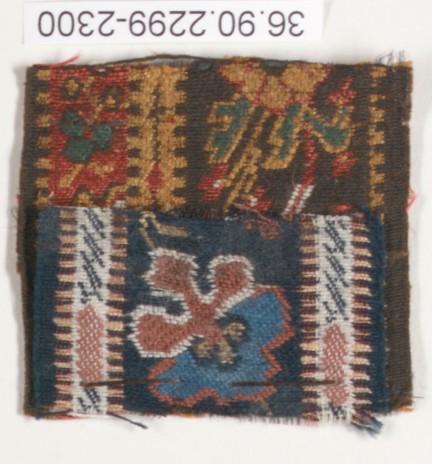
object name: border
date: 1801-1900